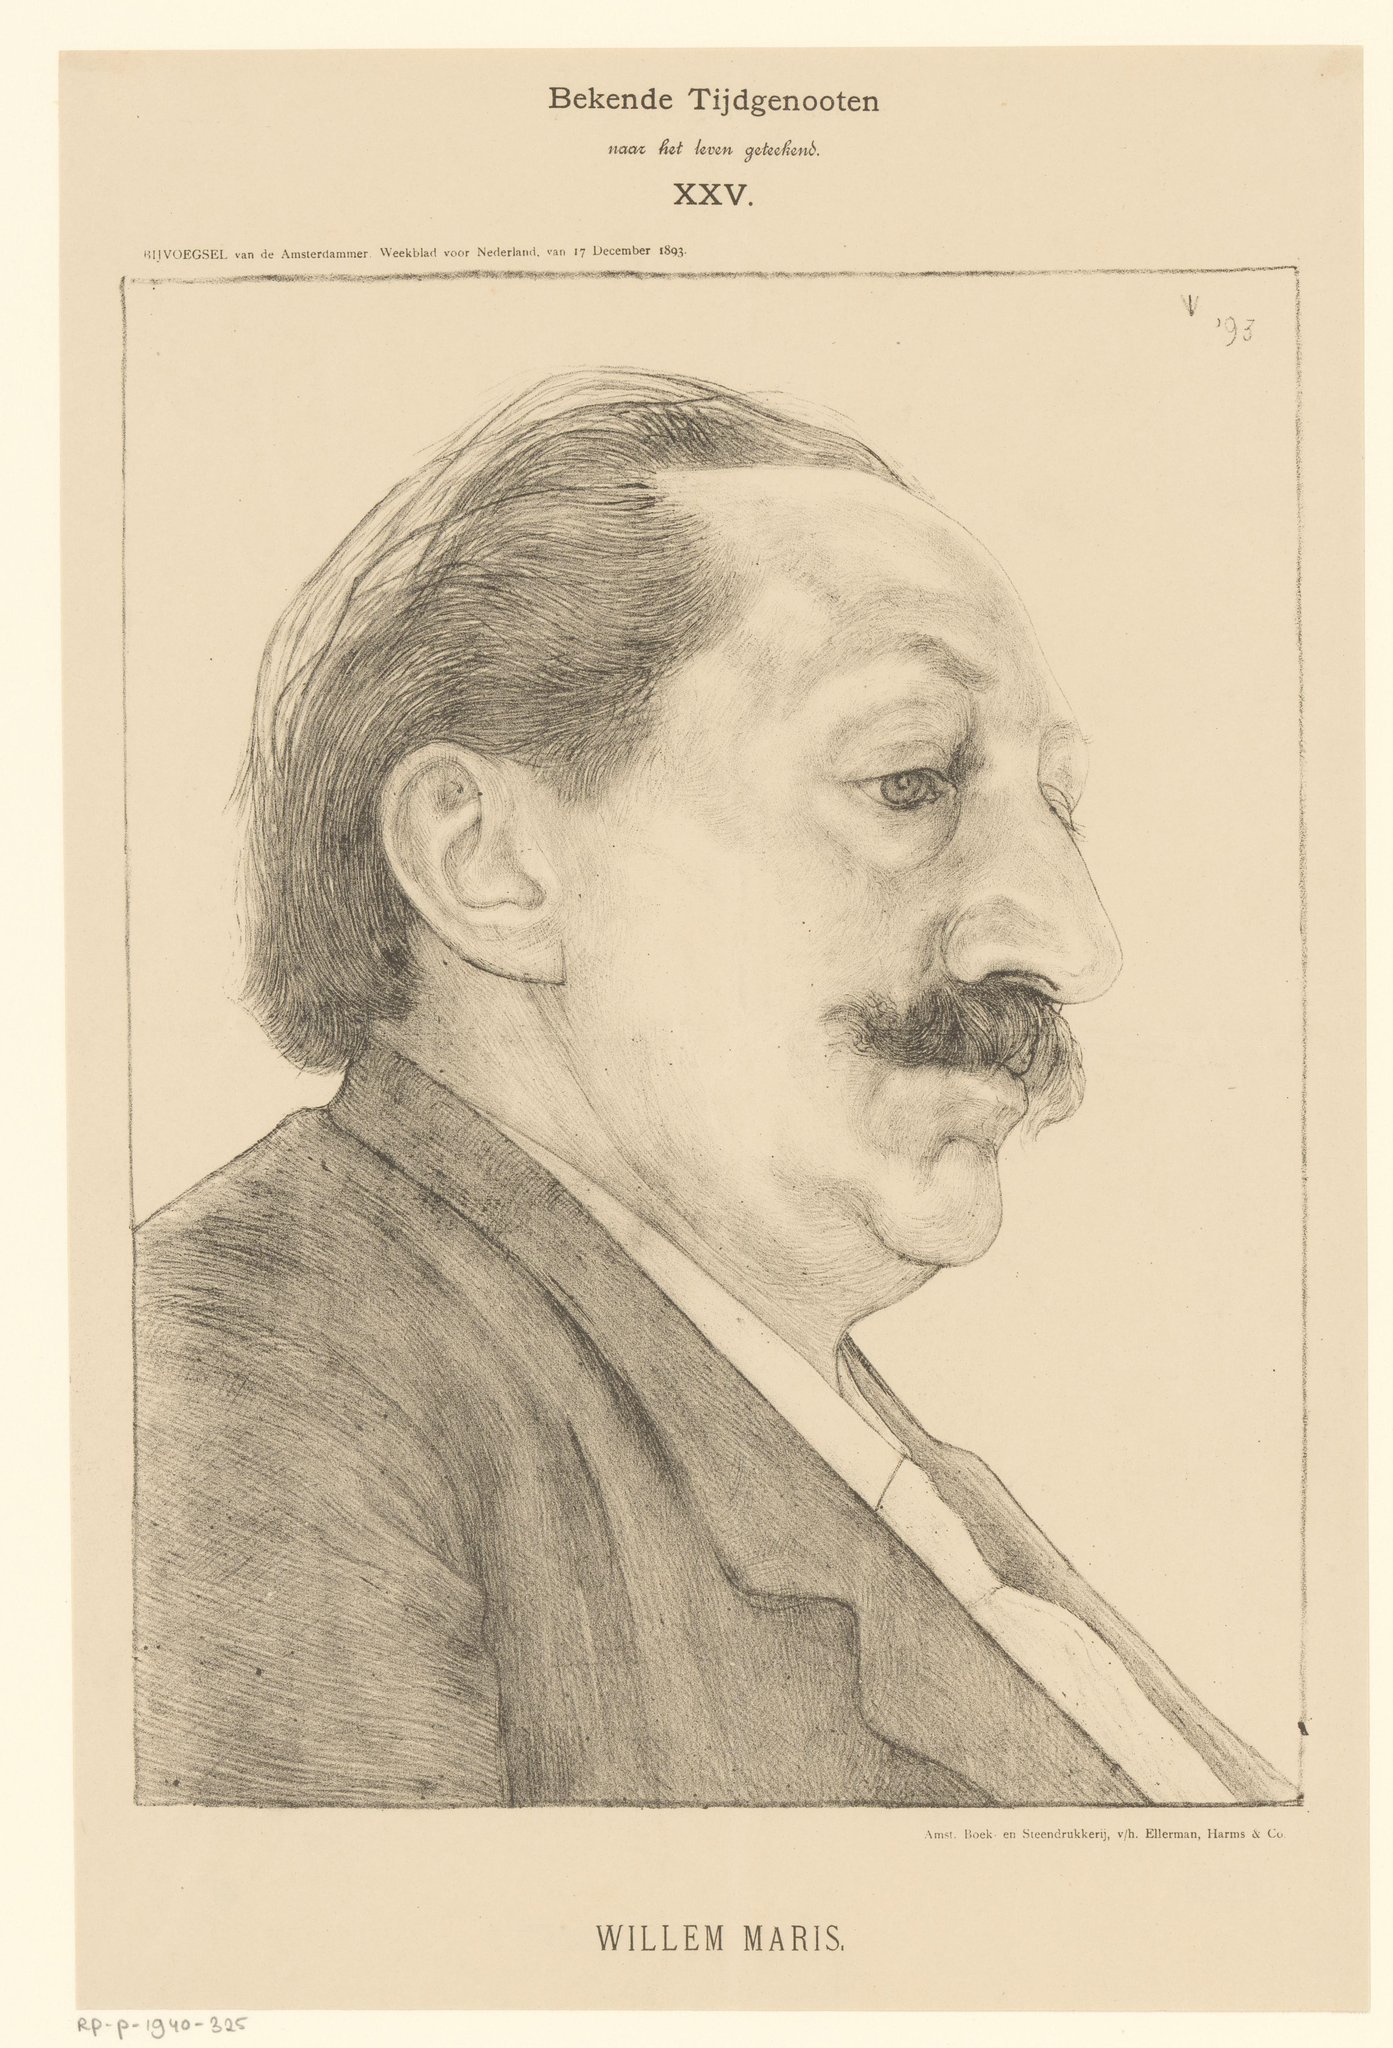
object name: print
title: Bekende tijdgenooten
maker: jan veth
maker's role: designer, draughtsman, painter, print maker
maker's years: 1864-1925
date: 1893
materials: paper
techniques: lithograph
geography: amsterdam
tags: the hague, painter, draughtsman, willem maris, historical persons (+ (full) bust portrait)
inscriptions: collector's mark: Lugt 2228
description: Deze prent werd uitgegeven bij De Amsterdammer op 17 december 1893.